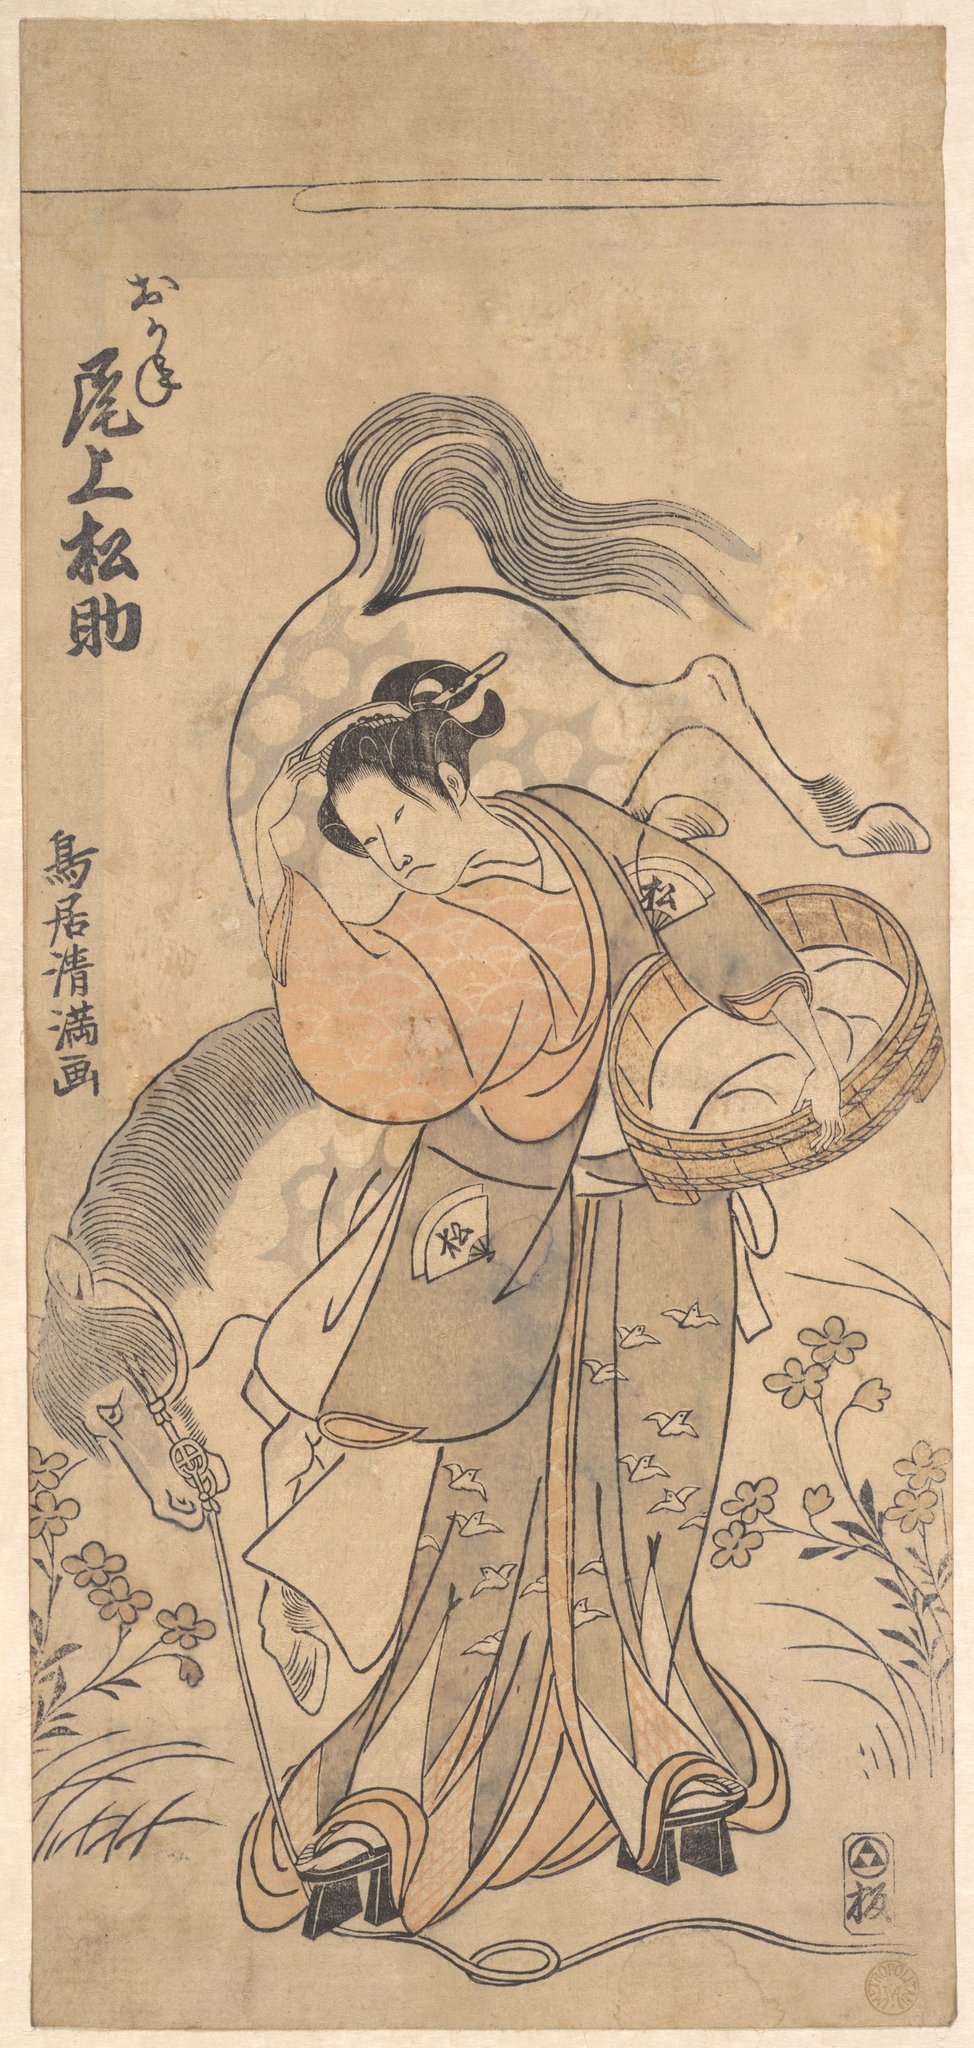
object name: print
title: The Actor Onoe Matsusuke in the Role of the Famous Strong Woman Okane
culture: japanese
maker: torii kiyomitsu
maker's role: artist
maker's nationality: japanese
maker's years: 1735-1785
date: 1765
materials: ink, paper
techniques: woodblock print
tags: human figures,horses,actors